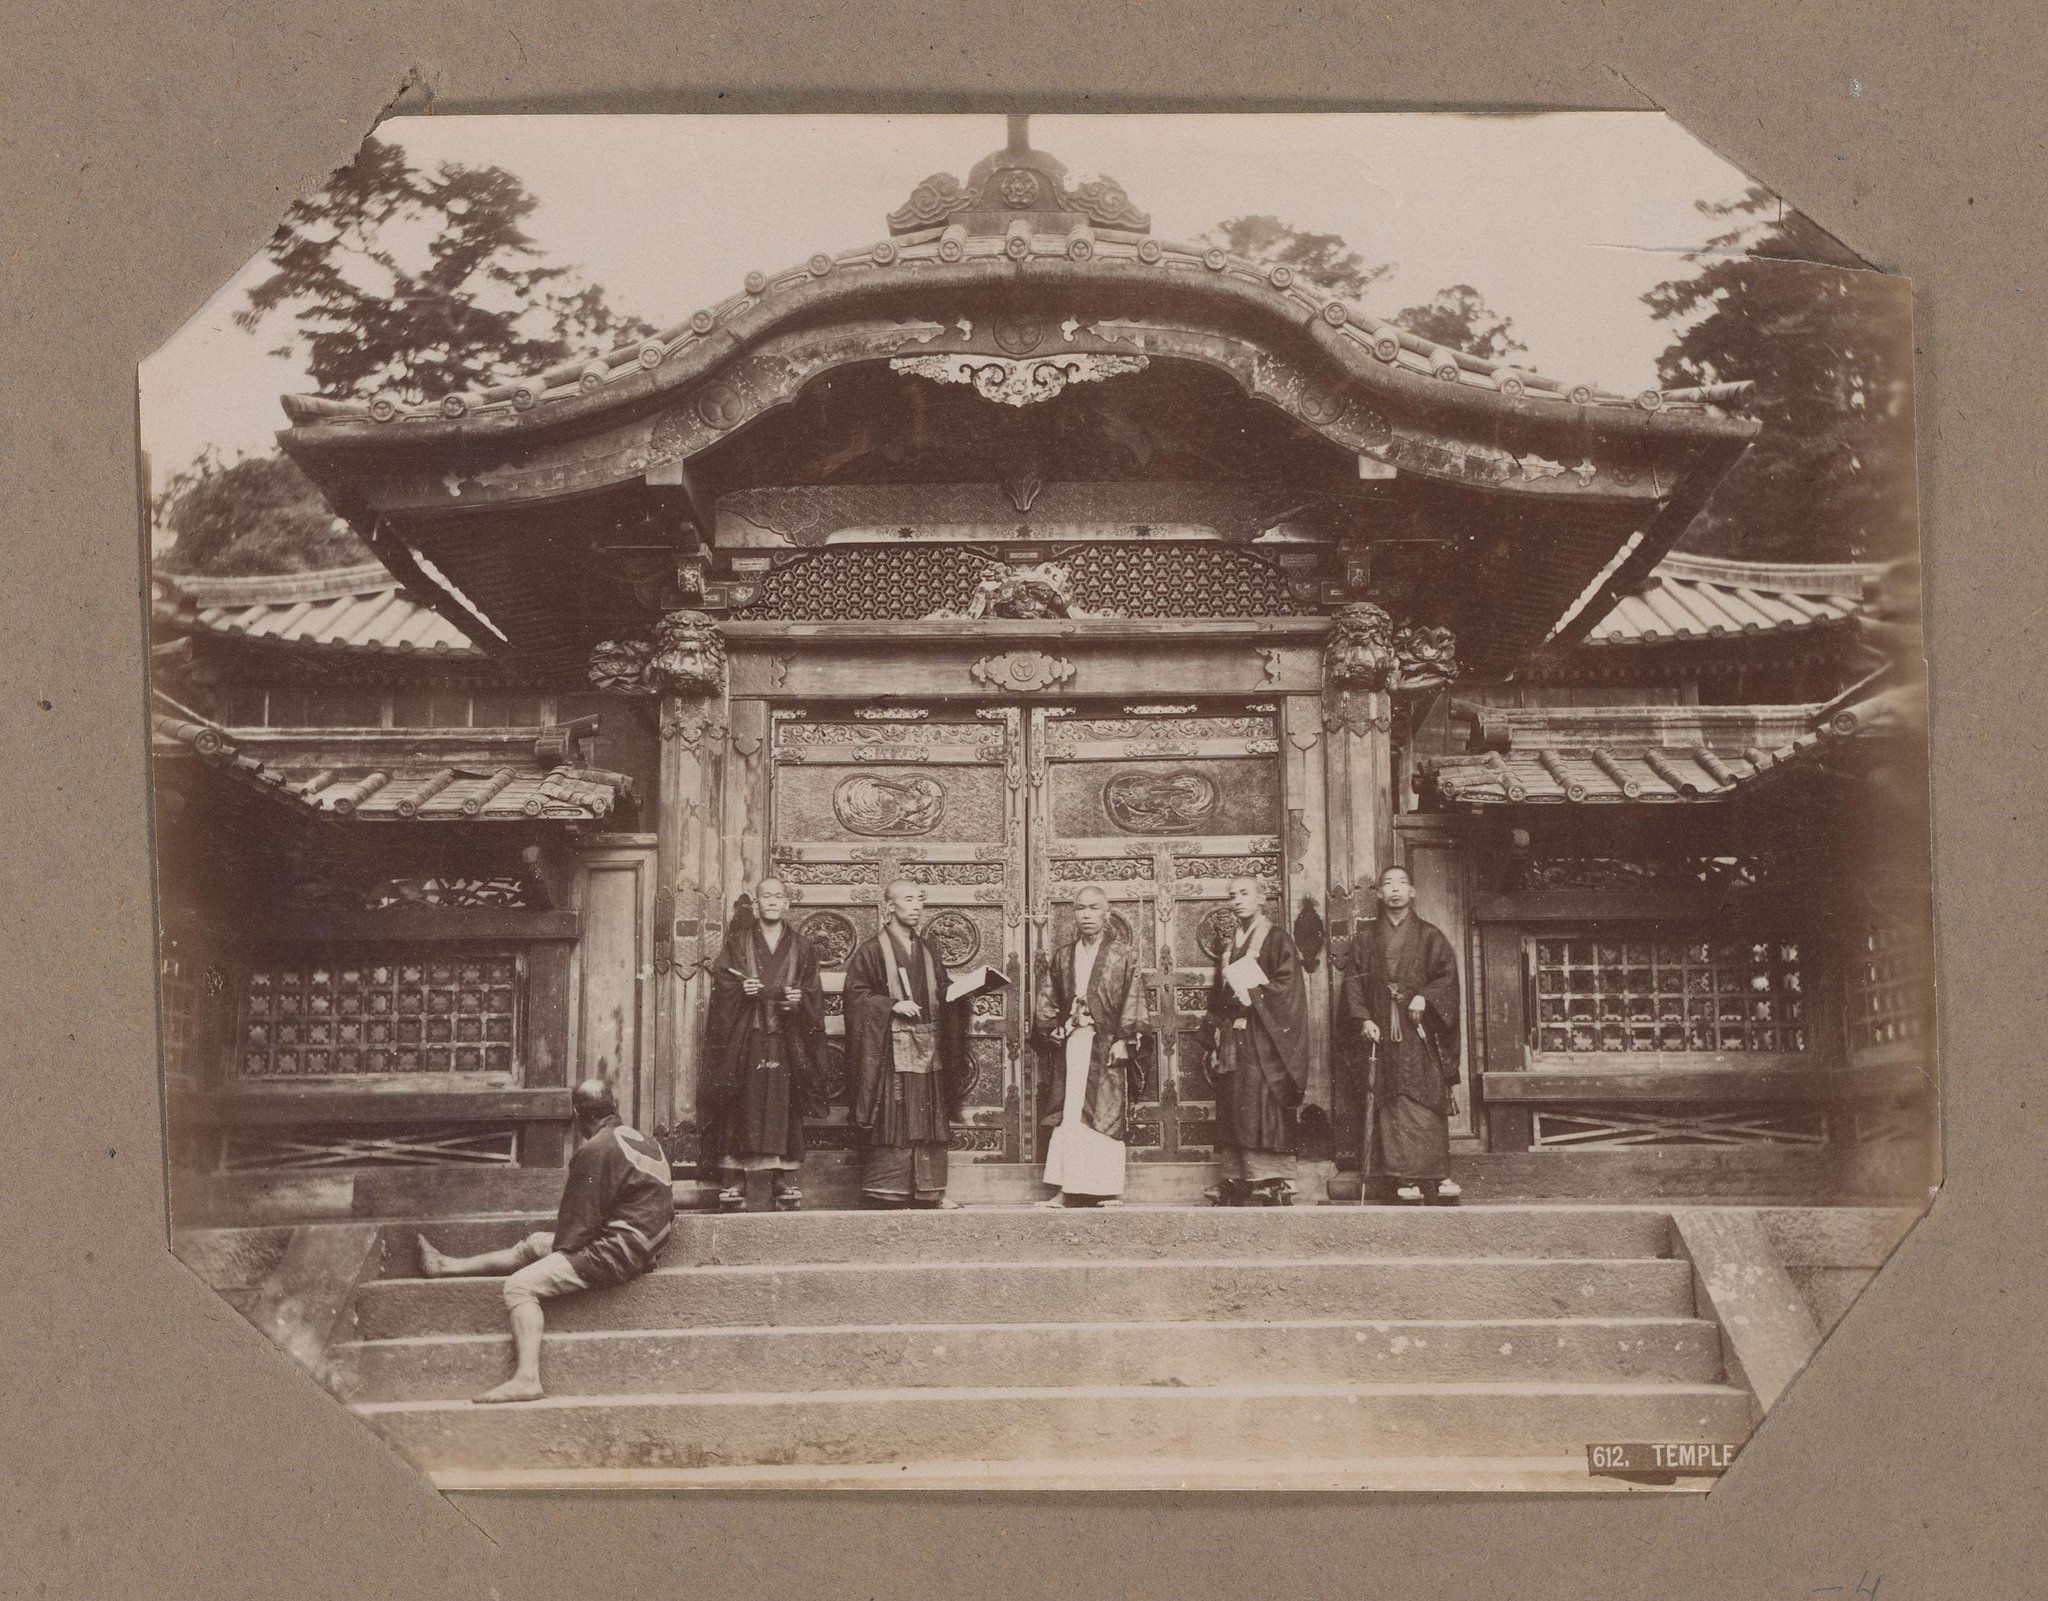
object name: photograph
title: Mannen bij de poort van een tempel in Shiba, Tokyo, Japan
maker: kusakabe kimbei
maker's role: fotograaf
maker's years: 1841-1934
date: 1890-1903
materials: paper, photographic support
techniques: albumen print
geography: tokyo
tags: temple, shrine ~ shinto, adult man (+ six persons), gate, entrance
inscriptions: inscription: ‘612. Temple Shiba Tokio’